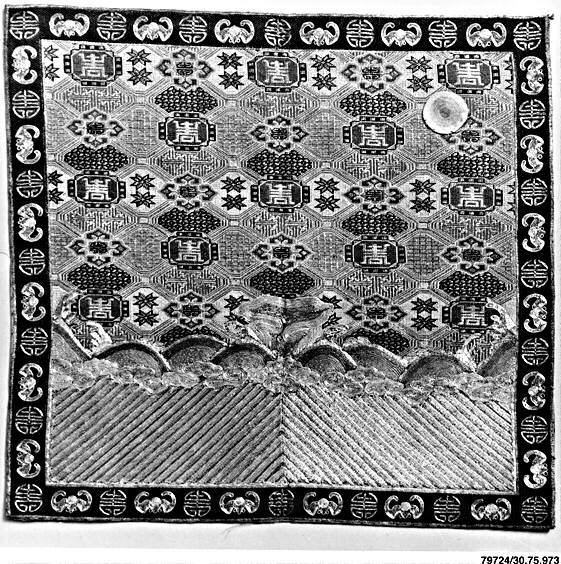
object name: rank badge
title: Rank Badge with Diaper Pattern and Wave Design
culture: chinese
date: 1767-1833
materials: metal thread, silk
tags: bats